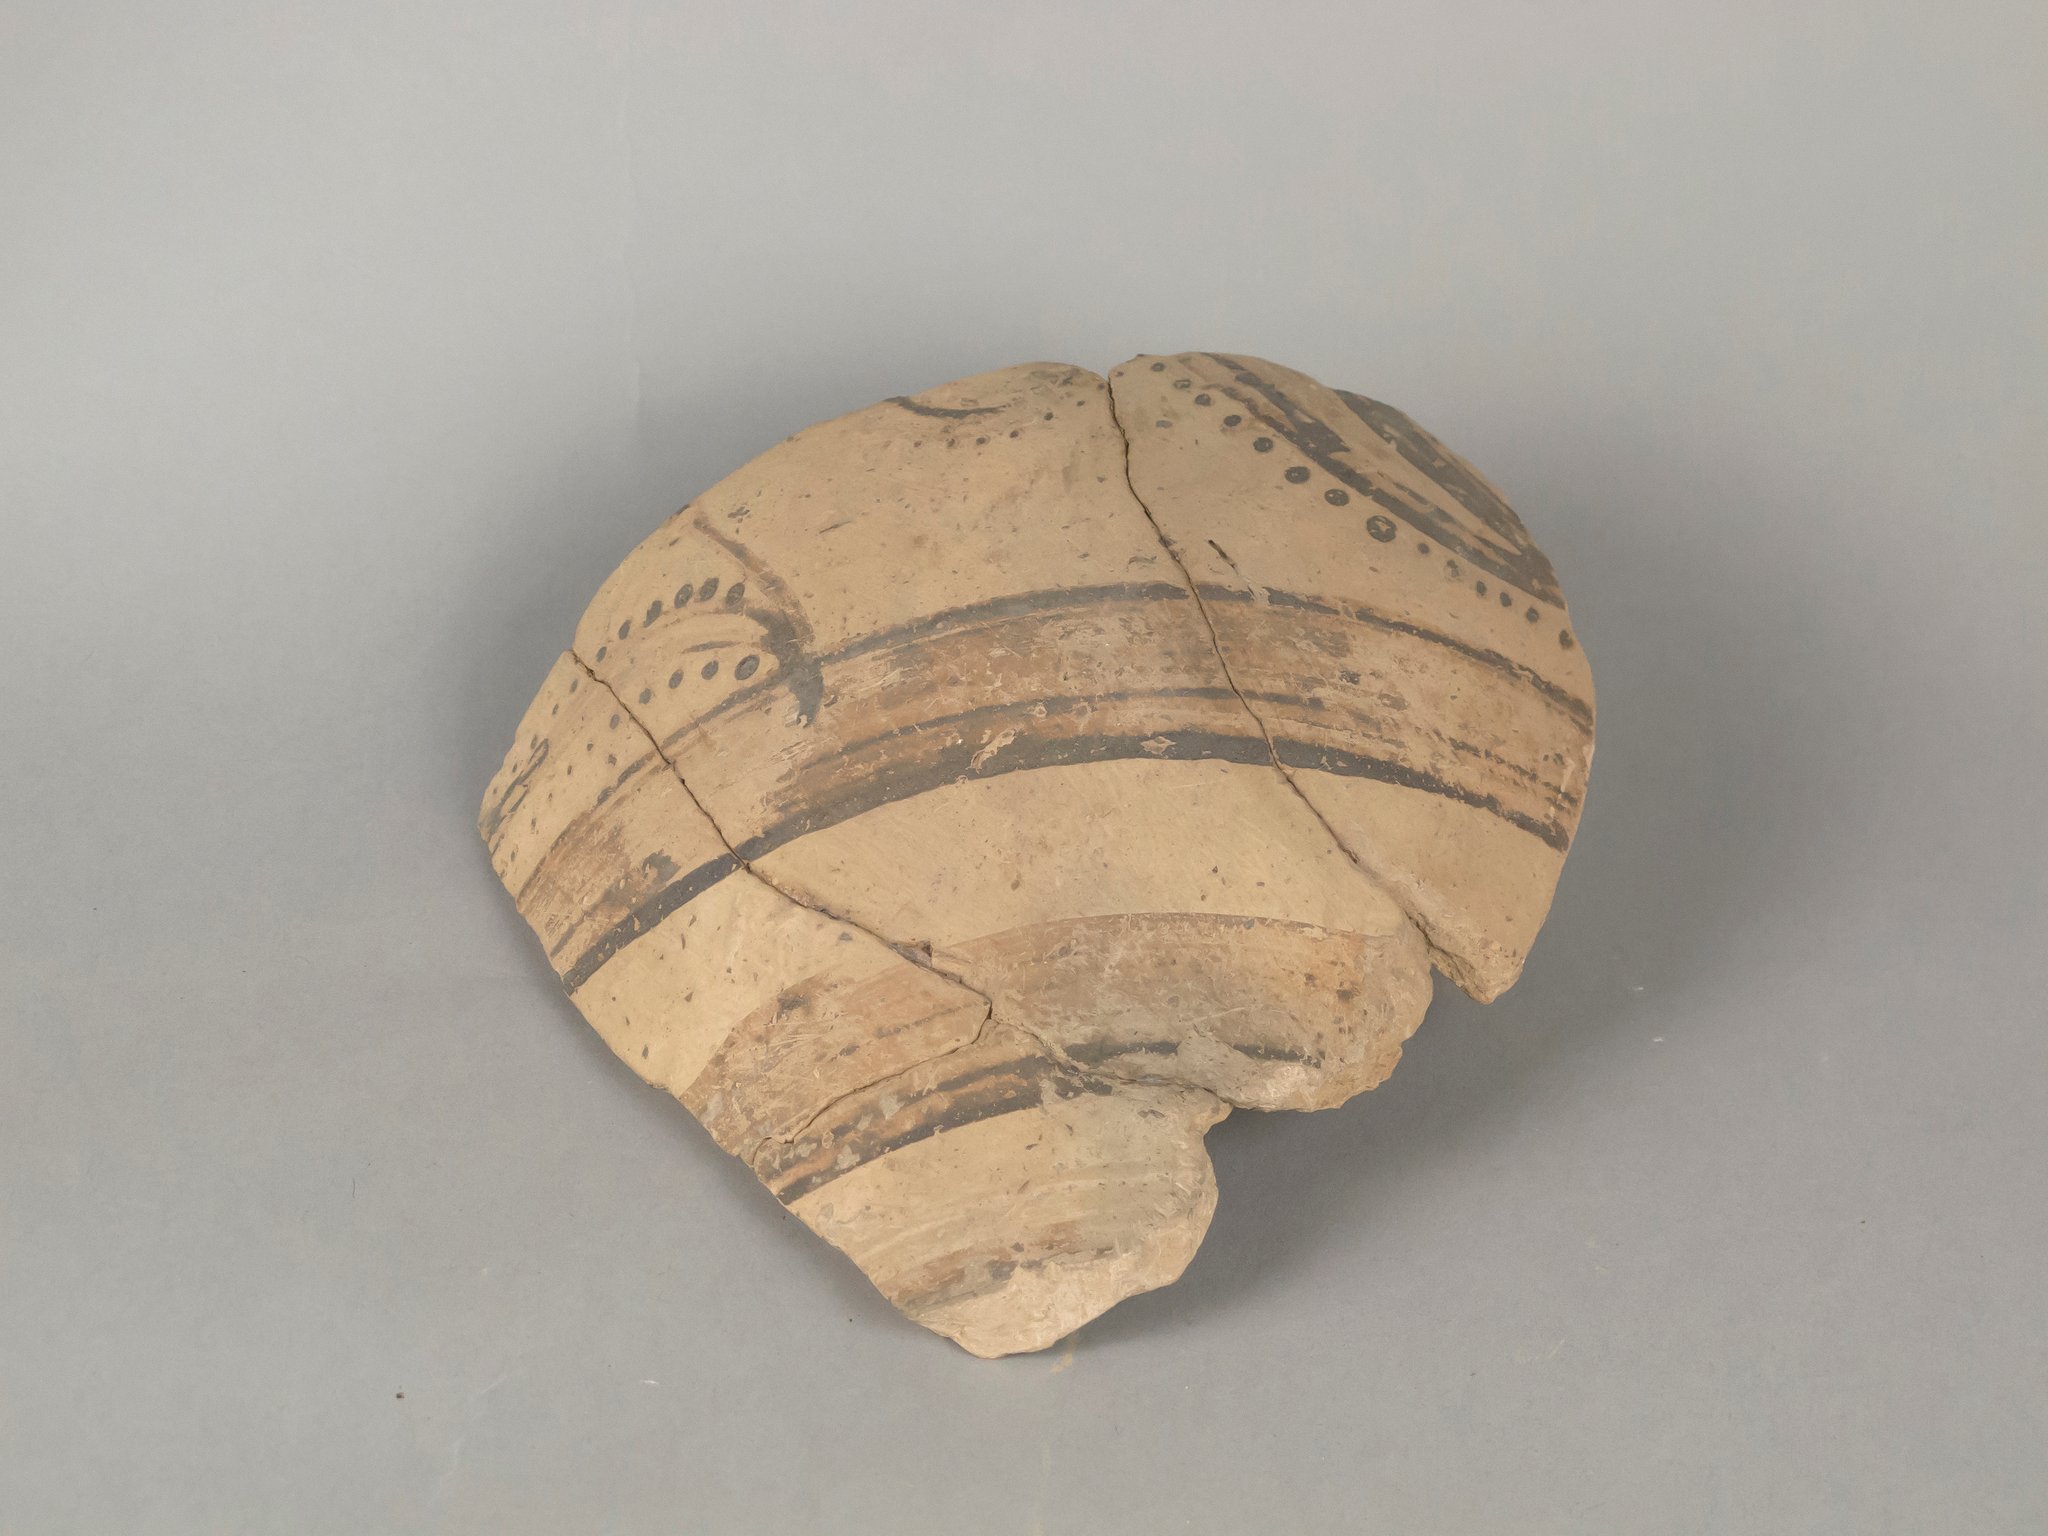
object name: vase fragment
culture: minoan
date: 1600-1450 BCE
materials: terracotta